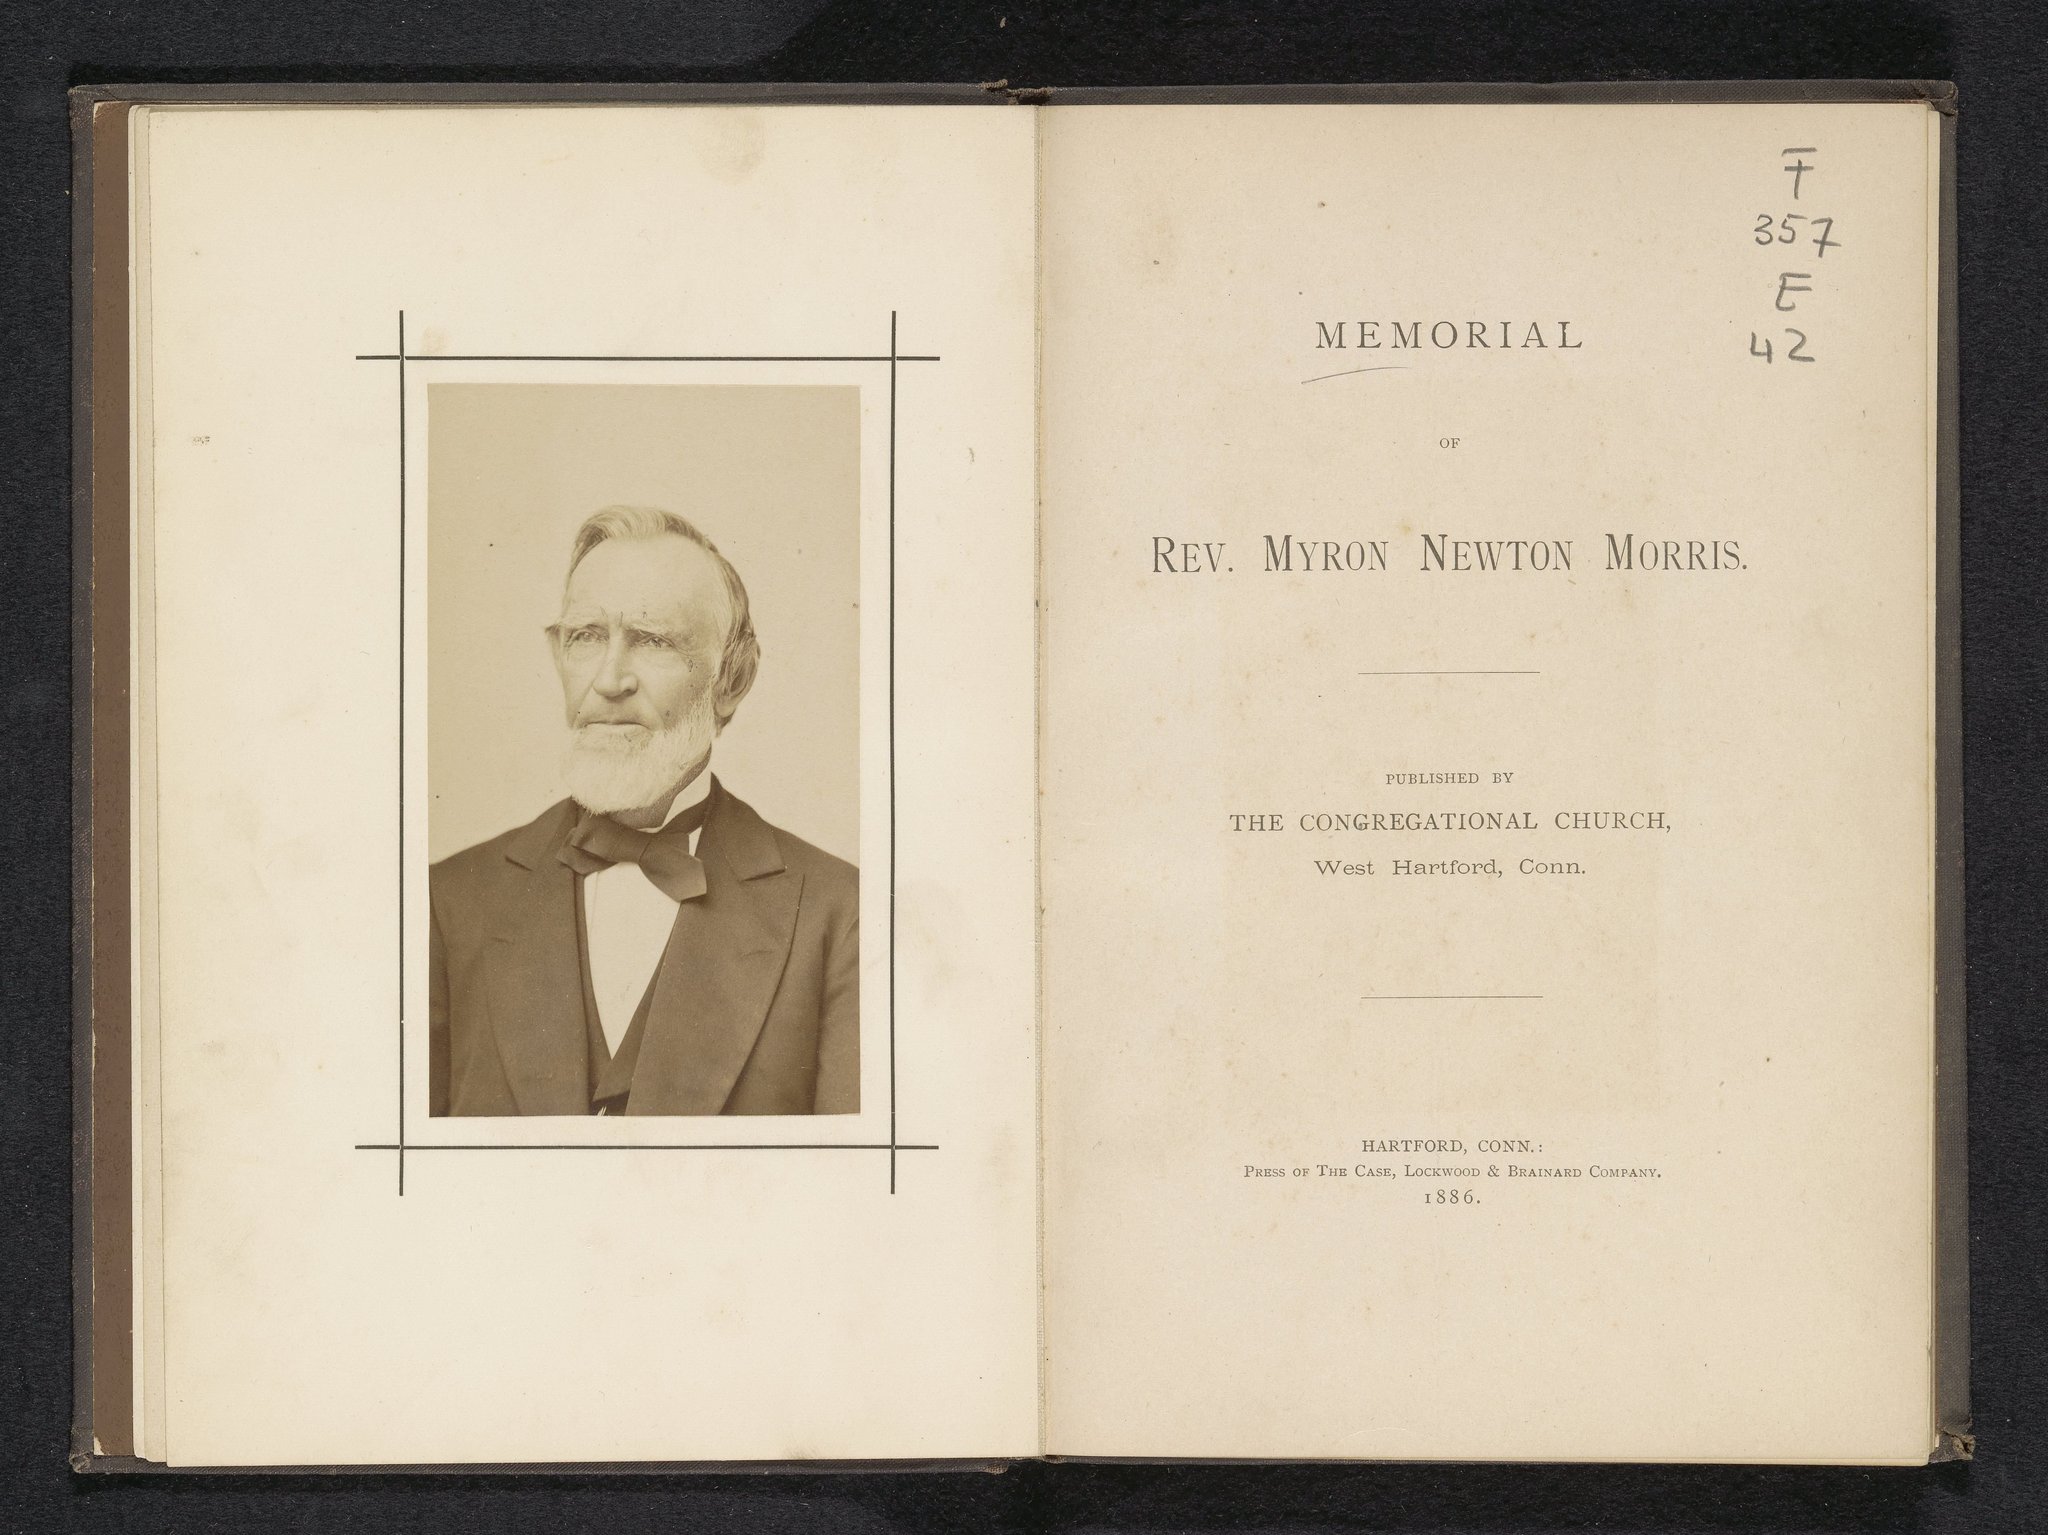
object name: page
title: Portret van Myron Newton Morris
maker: Anonymous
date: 1875-1885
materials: photographic support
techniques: albumen print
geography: united states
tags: politician, politician, e.g. party leader